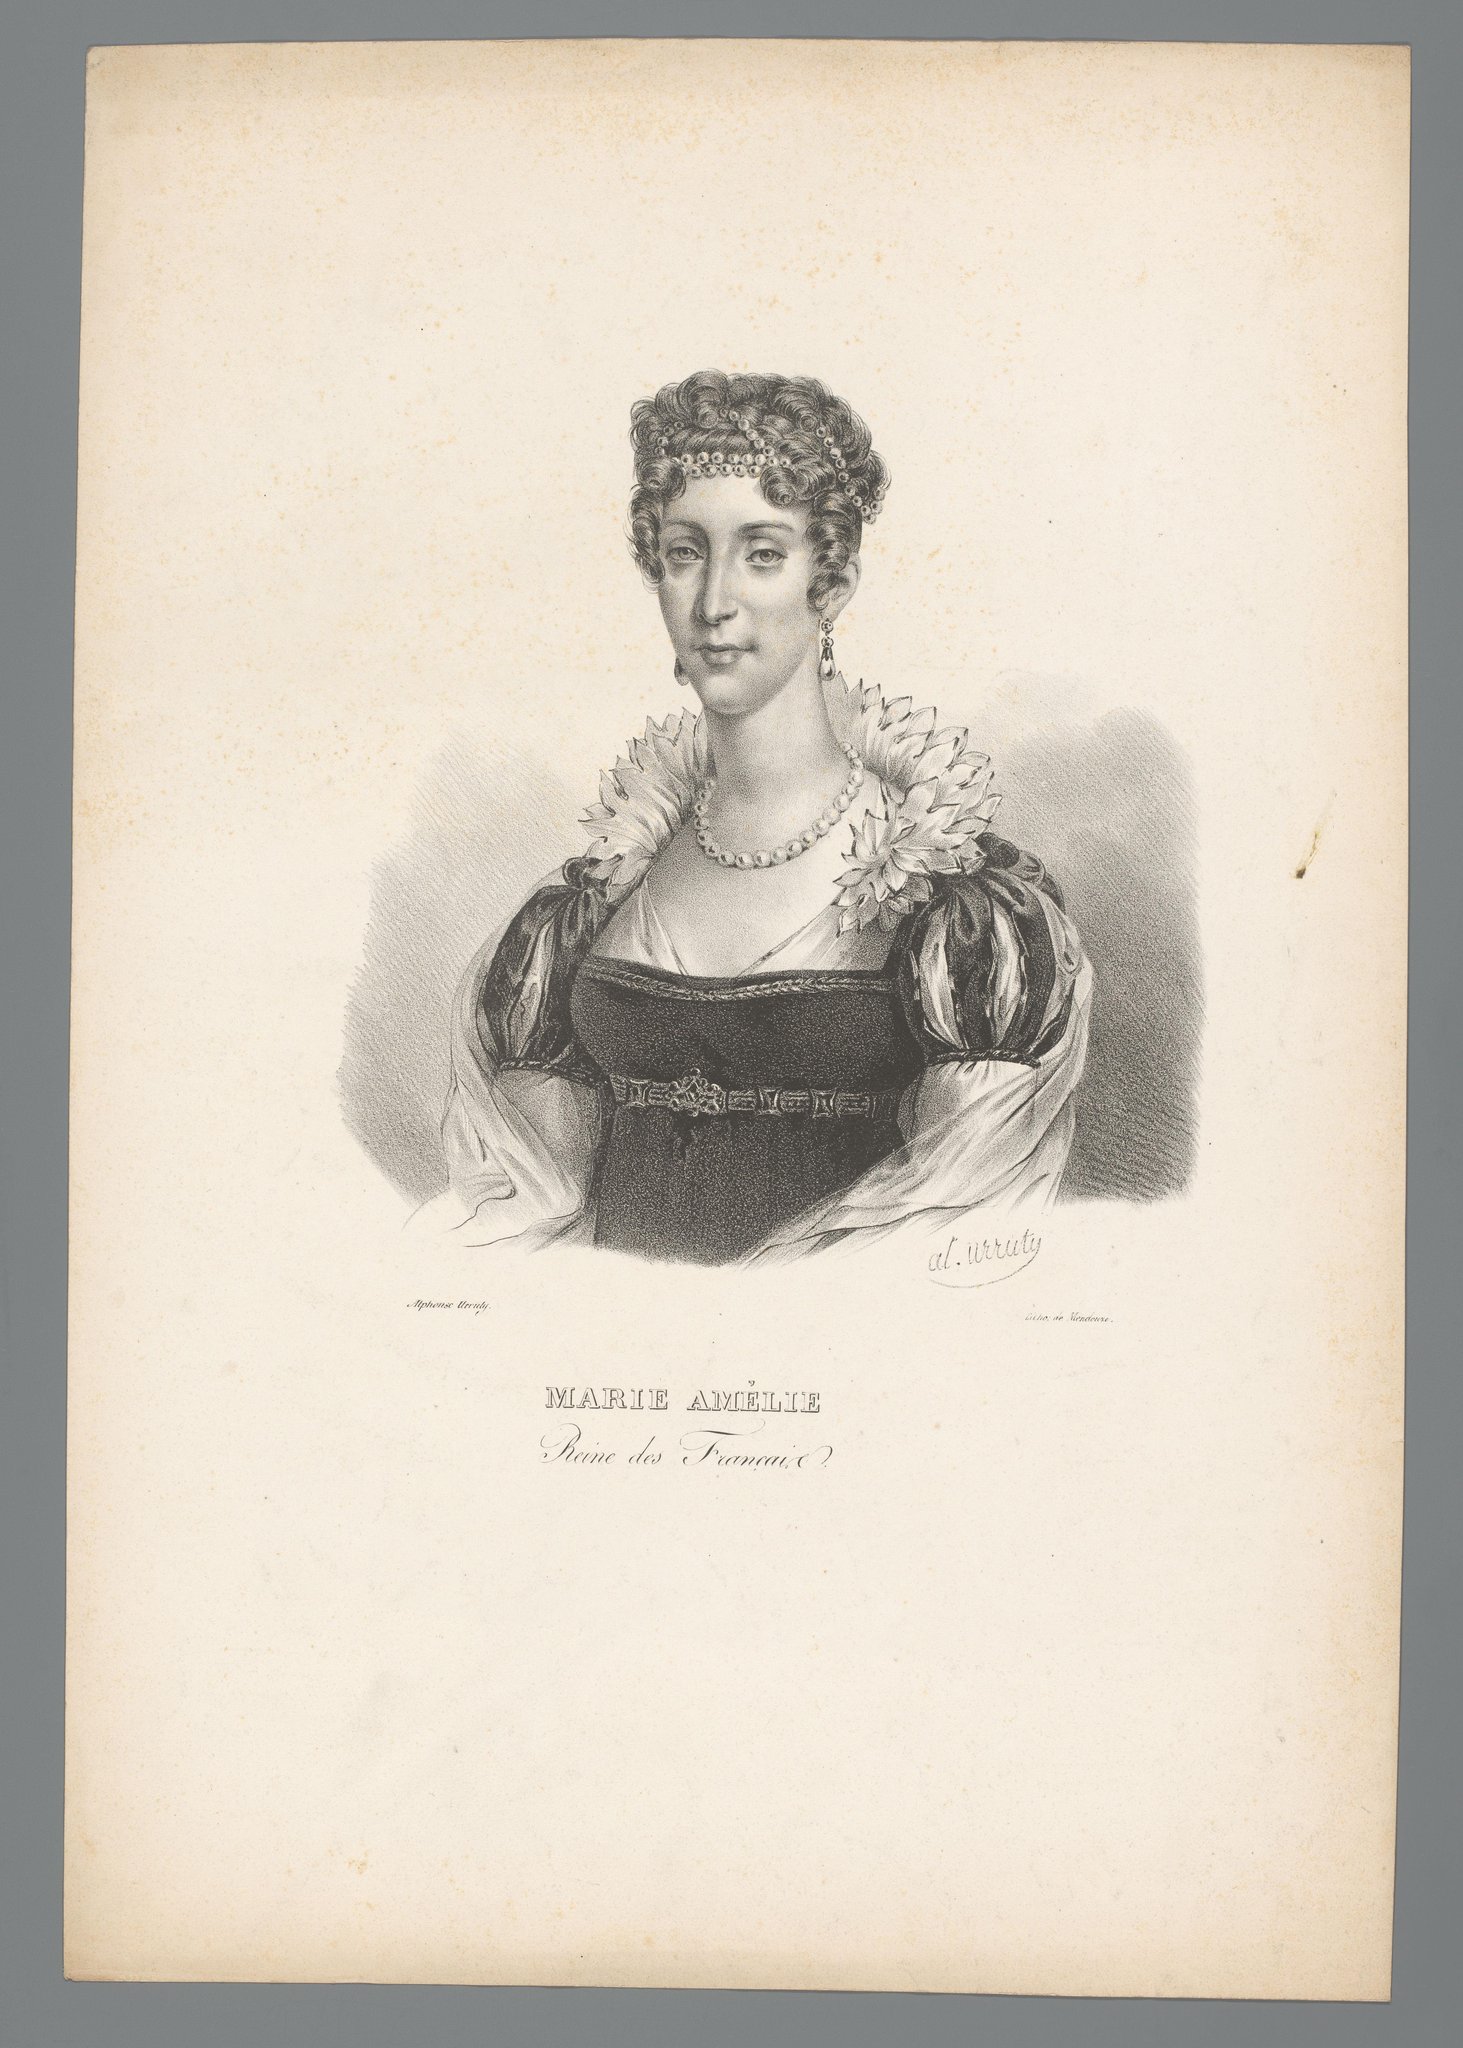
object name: print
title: Portret van koningin Marie Amélie van Bourbon-Sicilië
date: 1828-1834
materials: paper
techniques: lithograph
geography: paris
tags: caserta, london, historical persons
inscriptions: collector's mark: Lugt 2228